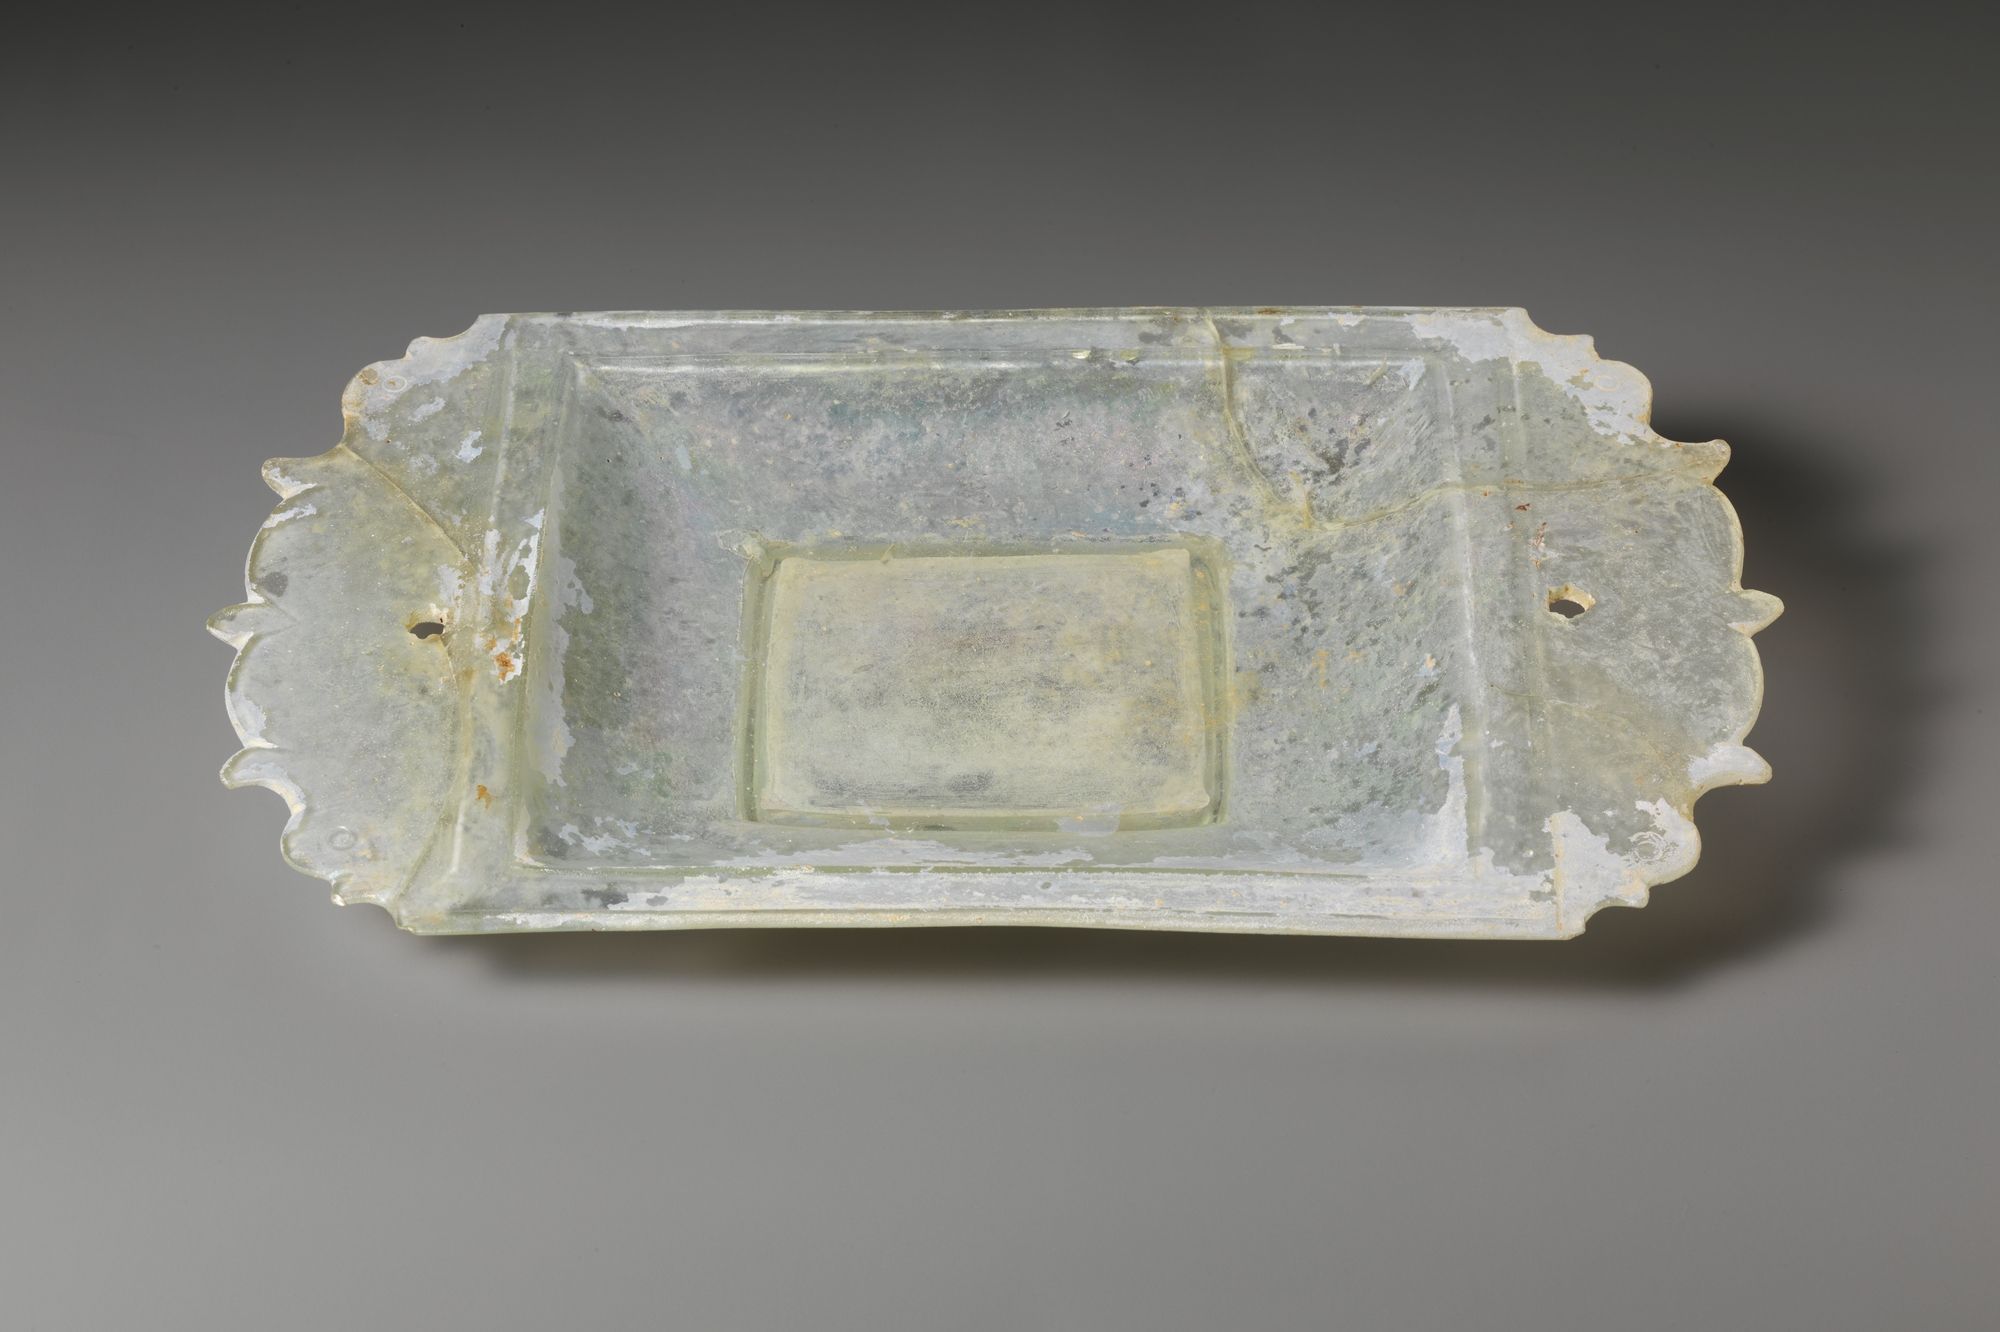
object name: tray, cast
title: Glass serving dish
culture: roman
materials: glass